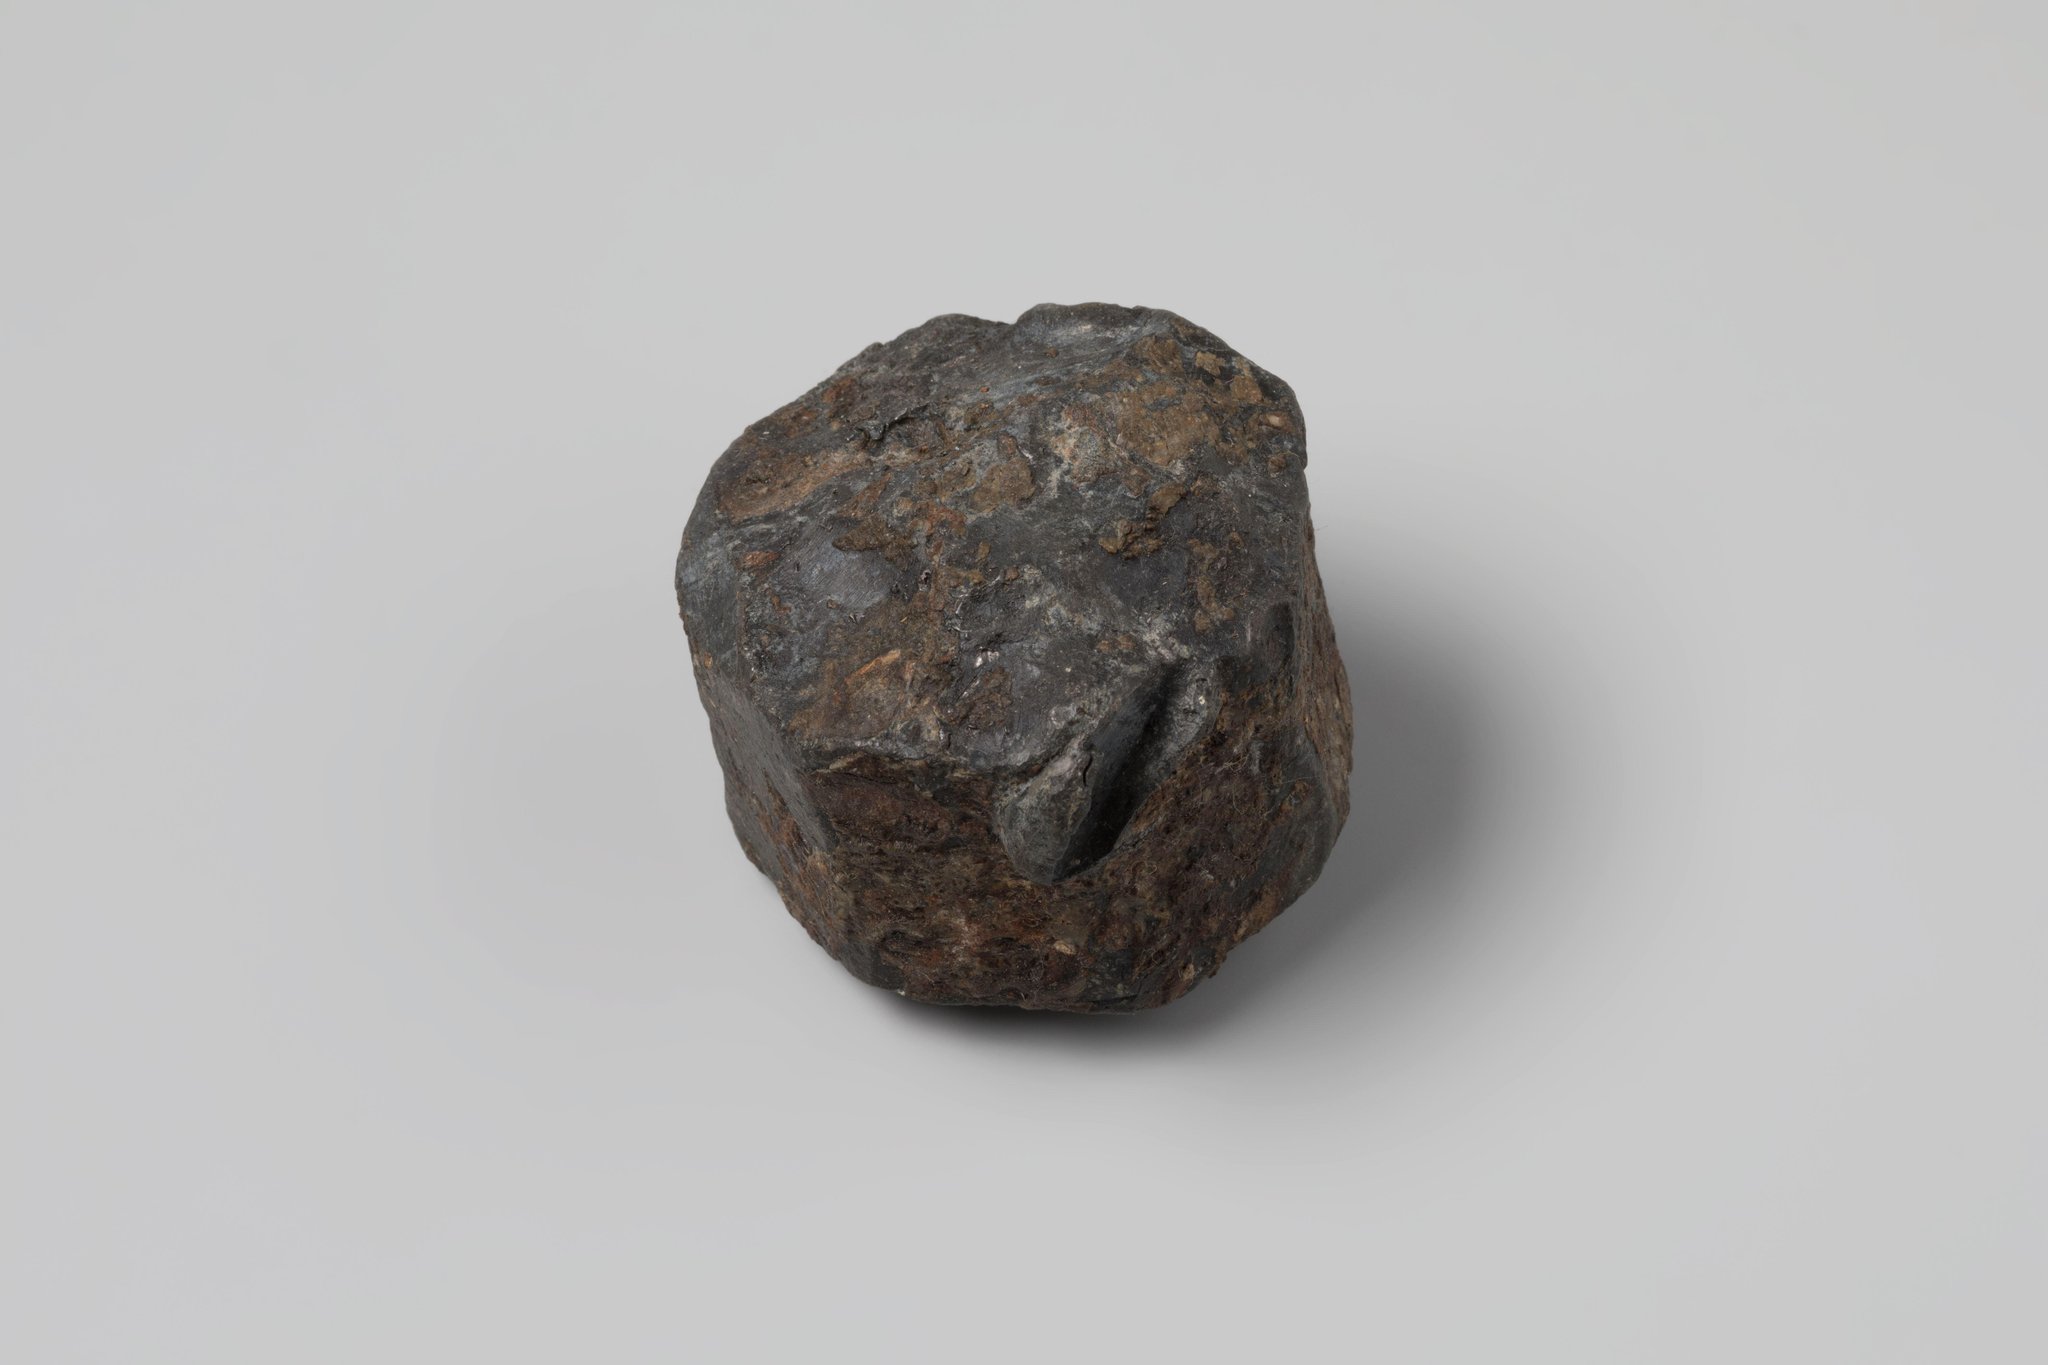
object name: sounding lead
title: Dieplood uit het wrak van de Oost-Indiëvaarder Hollandia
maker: Anonymous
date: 1700-1743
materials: lead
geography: netherlands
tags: verenigde oostindische compagnie, hollandia (schip), annet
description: Tools and instruments, navigation, sounding lead; fragm, id. NG 1980-27H3129.